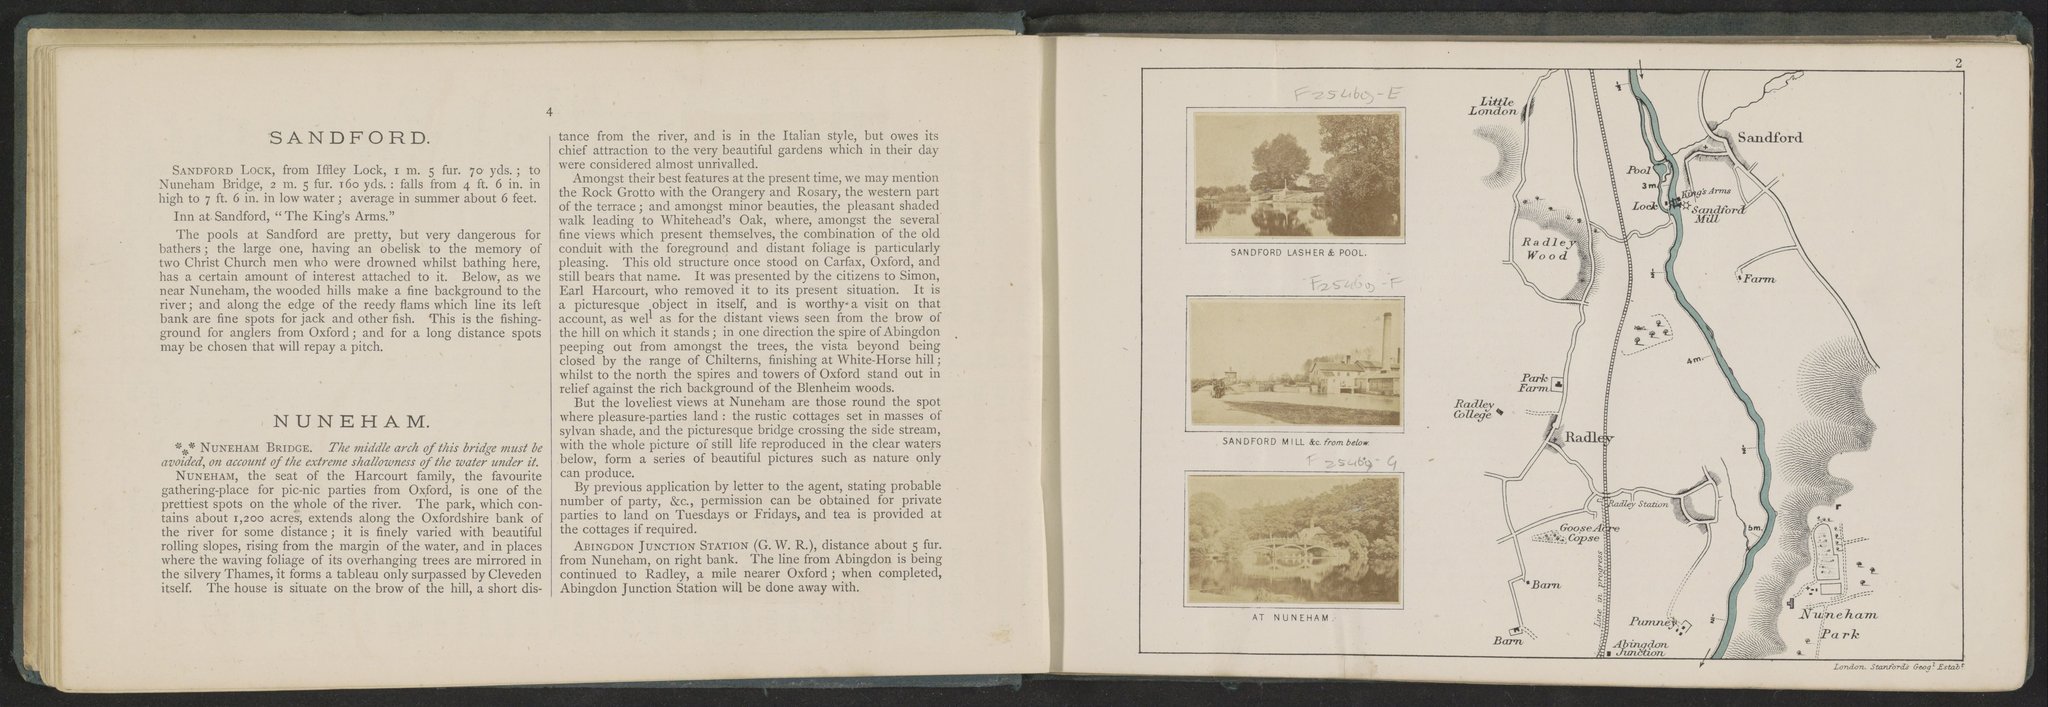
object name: photograph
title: Gezicht op een watermolen bij Sandford-on-Thames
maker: henry w. taunt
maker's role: fotograaf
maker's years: 1842-1922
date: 1871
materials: photographic support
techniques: albumen print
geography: sandford-on-thames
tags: watermill in landscape, thames